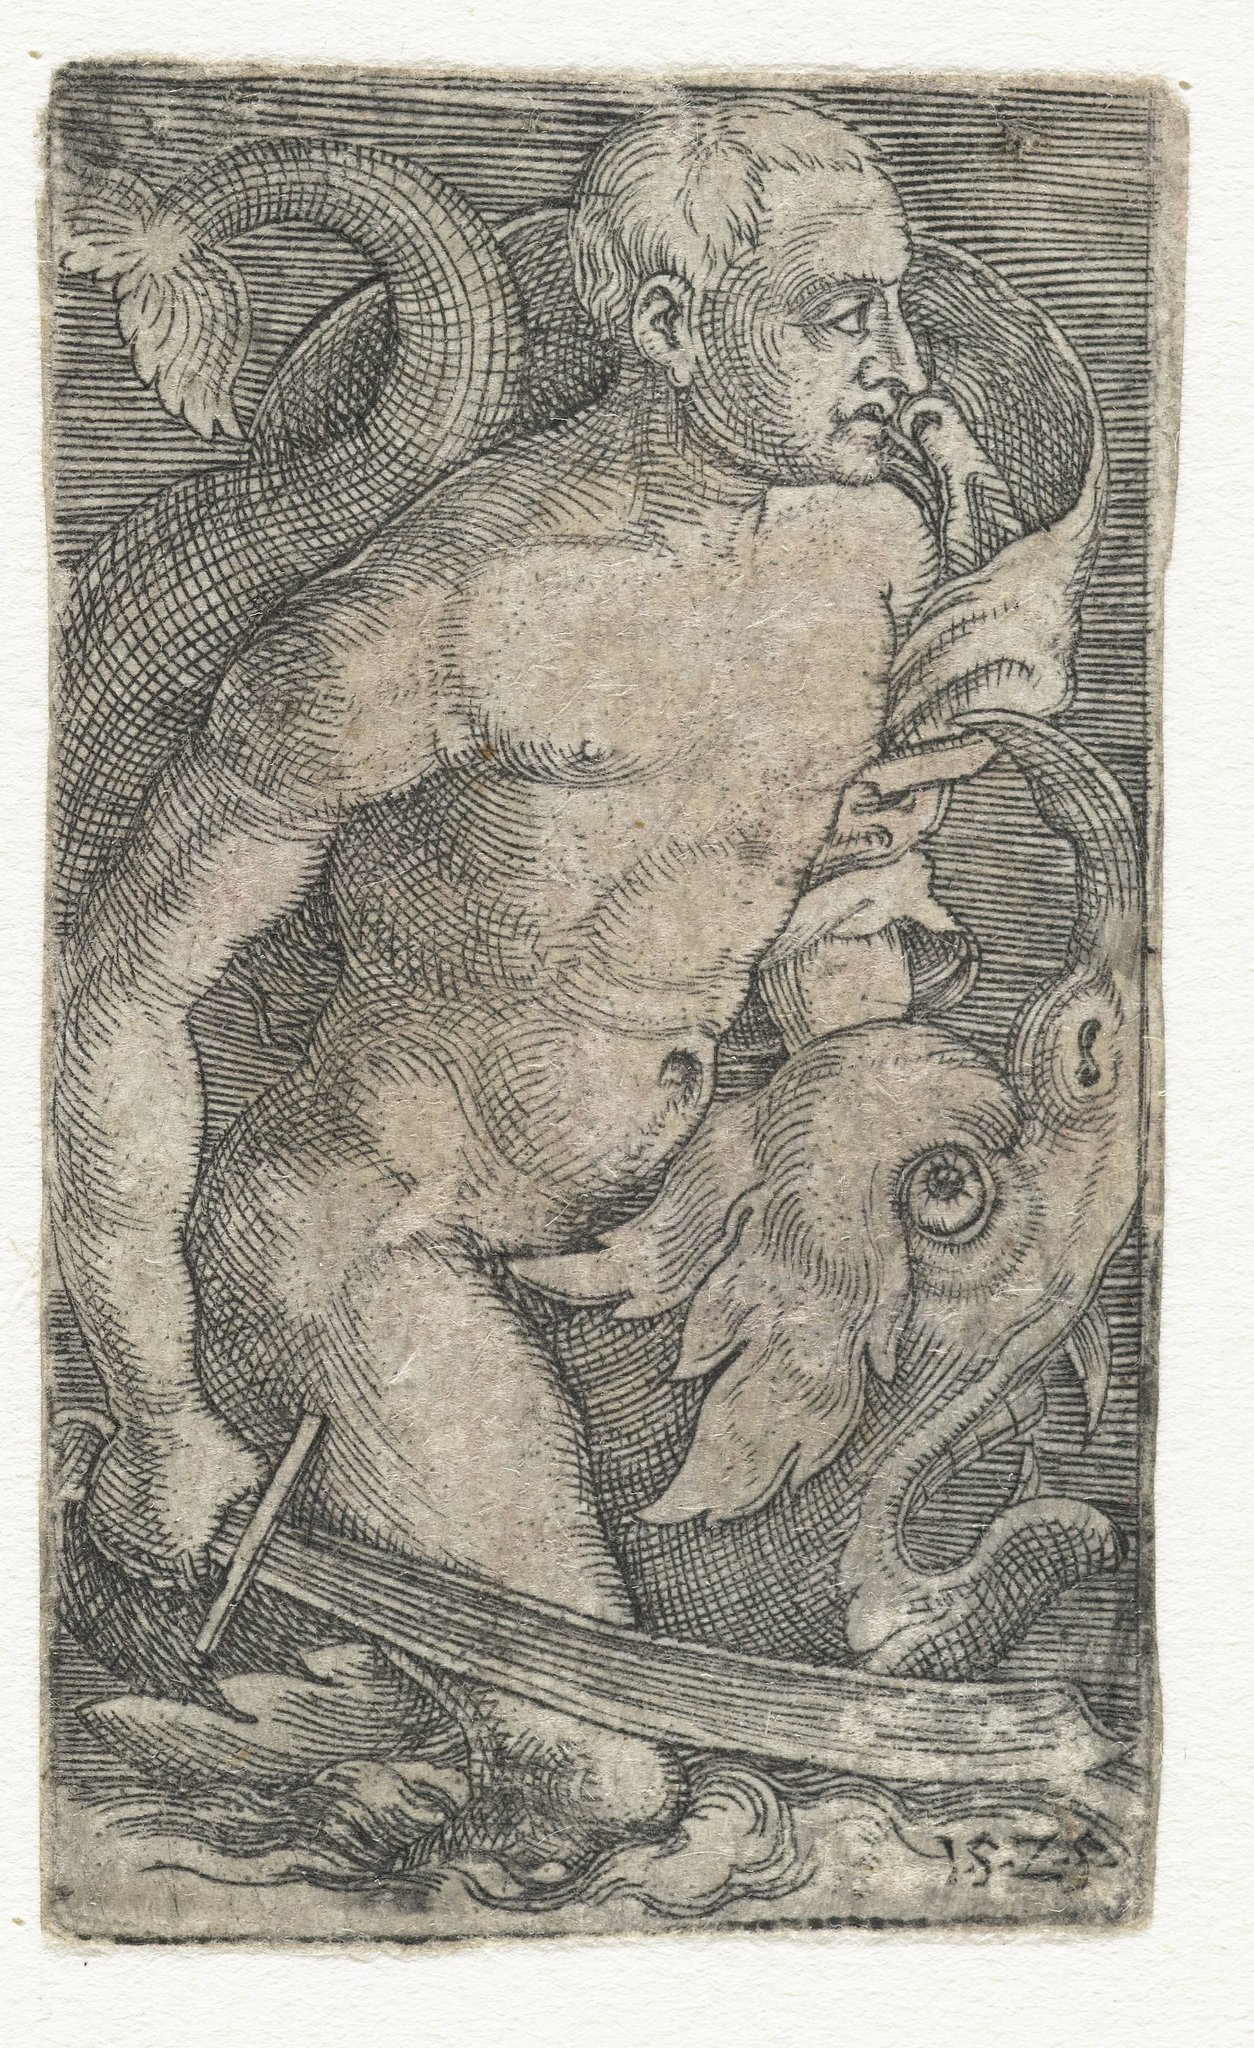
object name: print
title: Zeegod op dolfijn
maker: barthel beham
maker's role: print maker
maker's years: 1502-1540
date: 1525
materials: paper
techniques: engraving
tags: swimming mammals: dolphin, gods of the waters: the older dynasty (first series): offspring of pontus and the monsters of the sea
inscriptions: collector's mark: Lugt 240